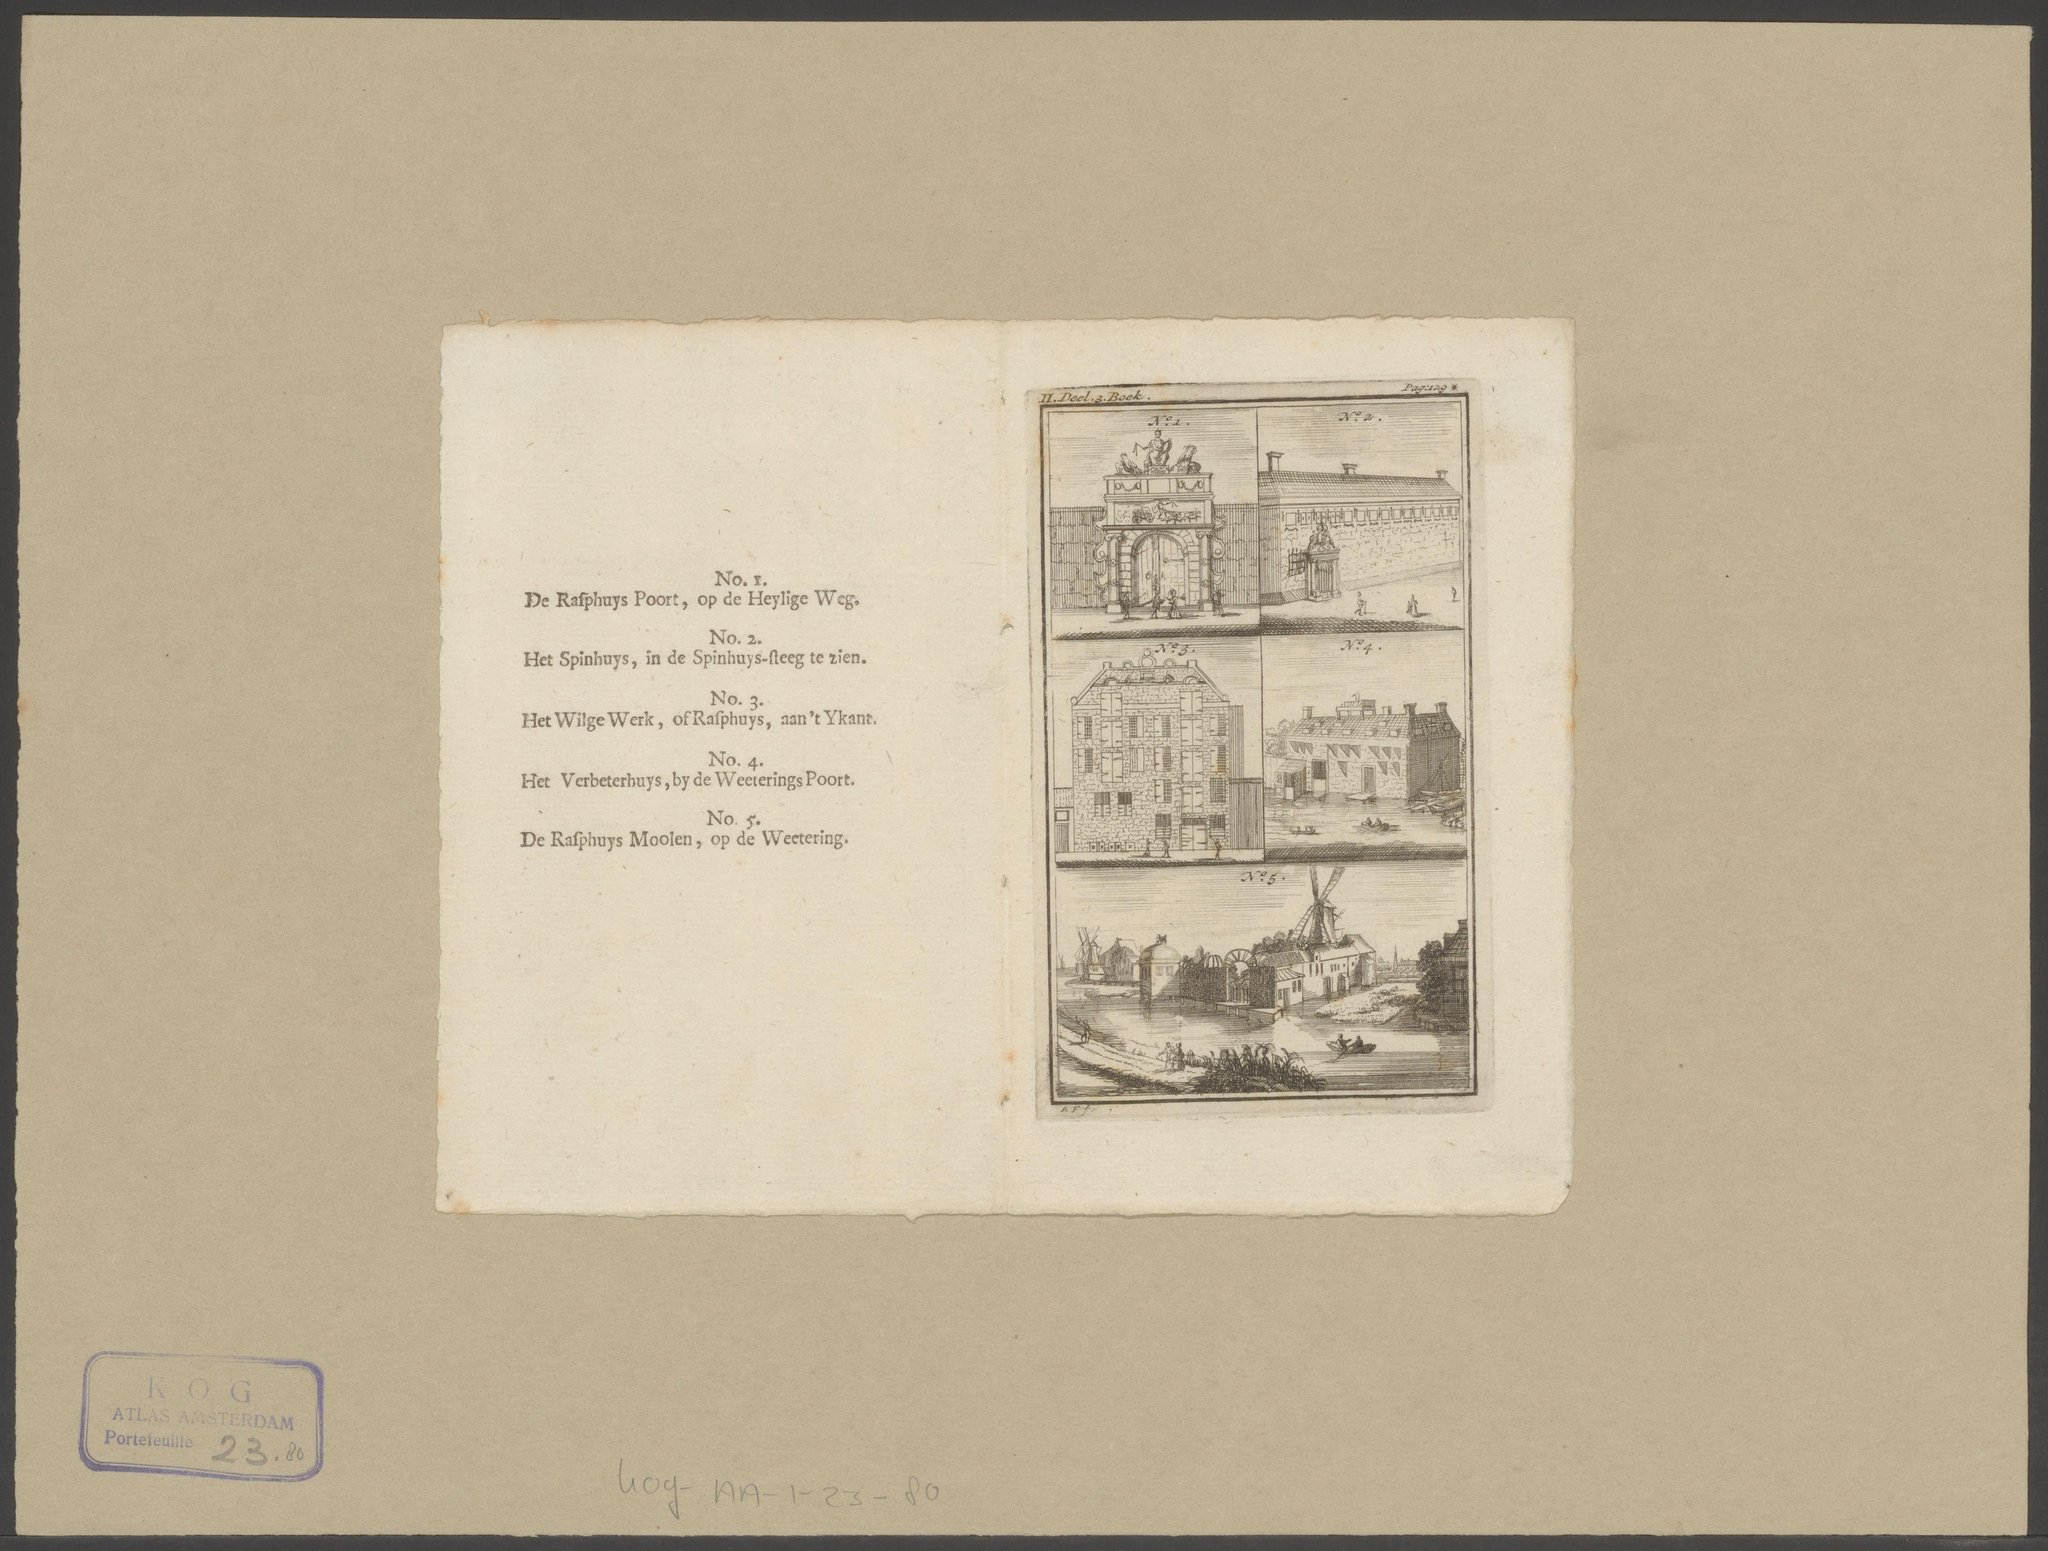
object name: print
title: Vijf verschillende tuchthuizen te Amsterdam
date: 1723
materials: paper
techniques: etching, letterpress printing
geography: amsterdam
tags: prison, jail, workhouse, penal camp, penitentiary, chain gang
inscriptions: collector's mark: Lugt 1641b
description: Prent uit: Leuve, Roeland van. 's Waerelds koopslot of De Amsteldamse beurs. Amsterdam: Jacobus Verheyden (I), 1723. Of uit: Leuven, Roeland van. 's Waerelds koopslot Of de Amsteldamse beurs. Amsterdam: Gerrit Bouman, 1730.